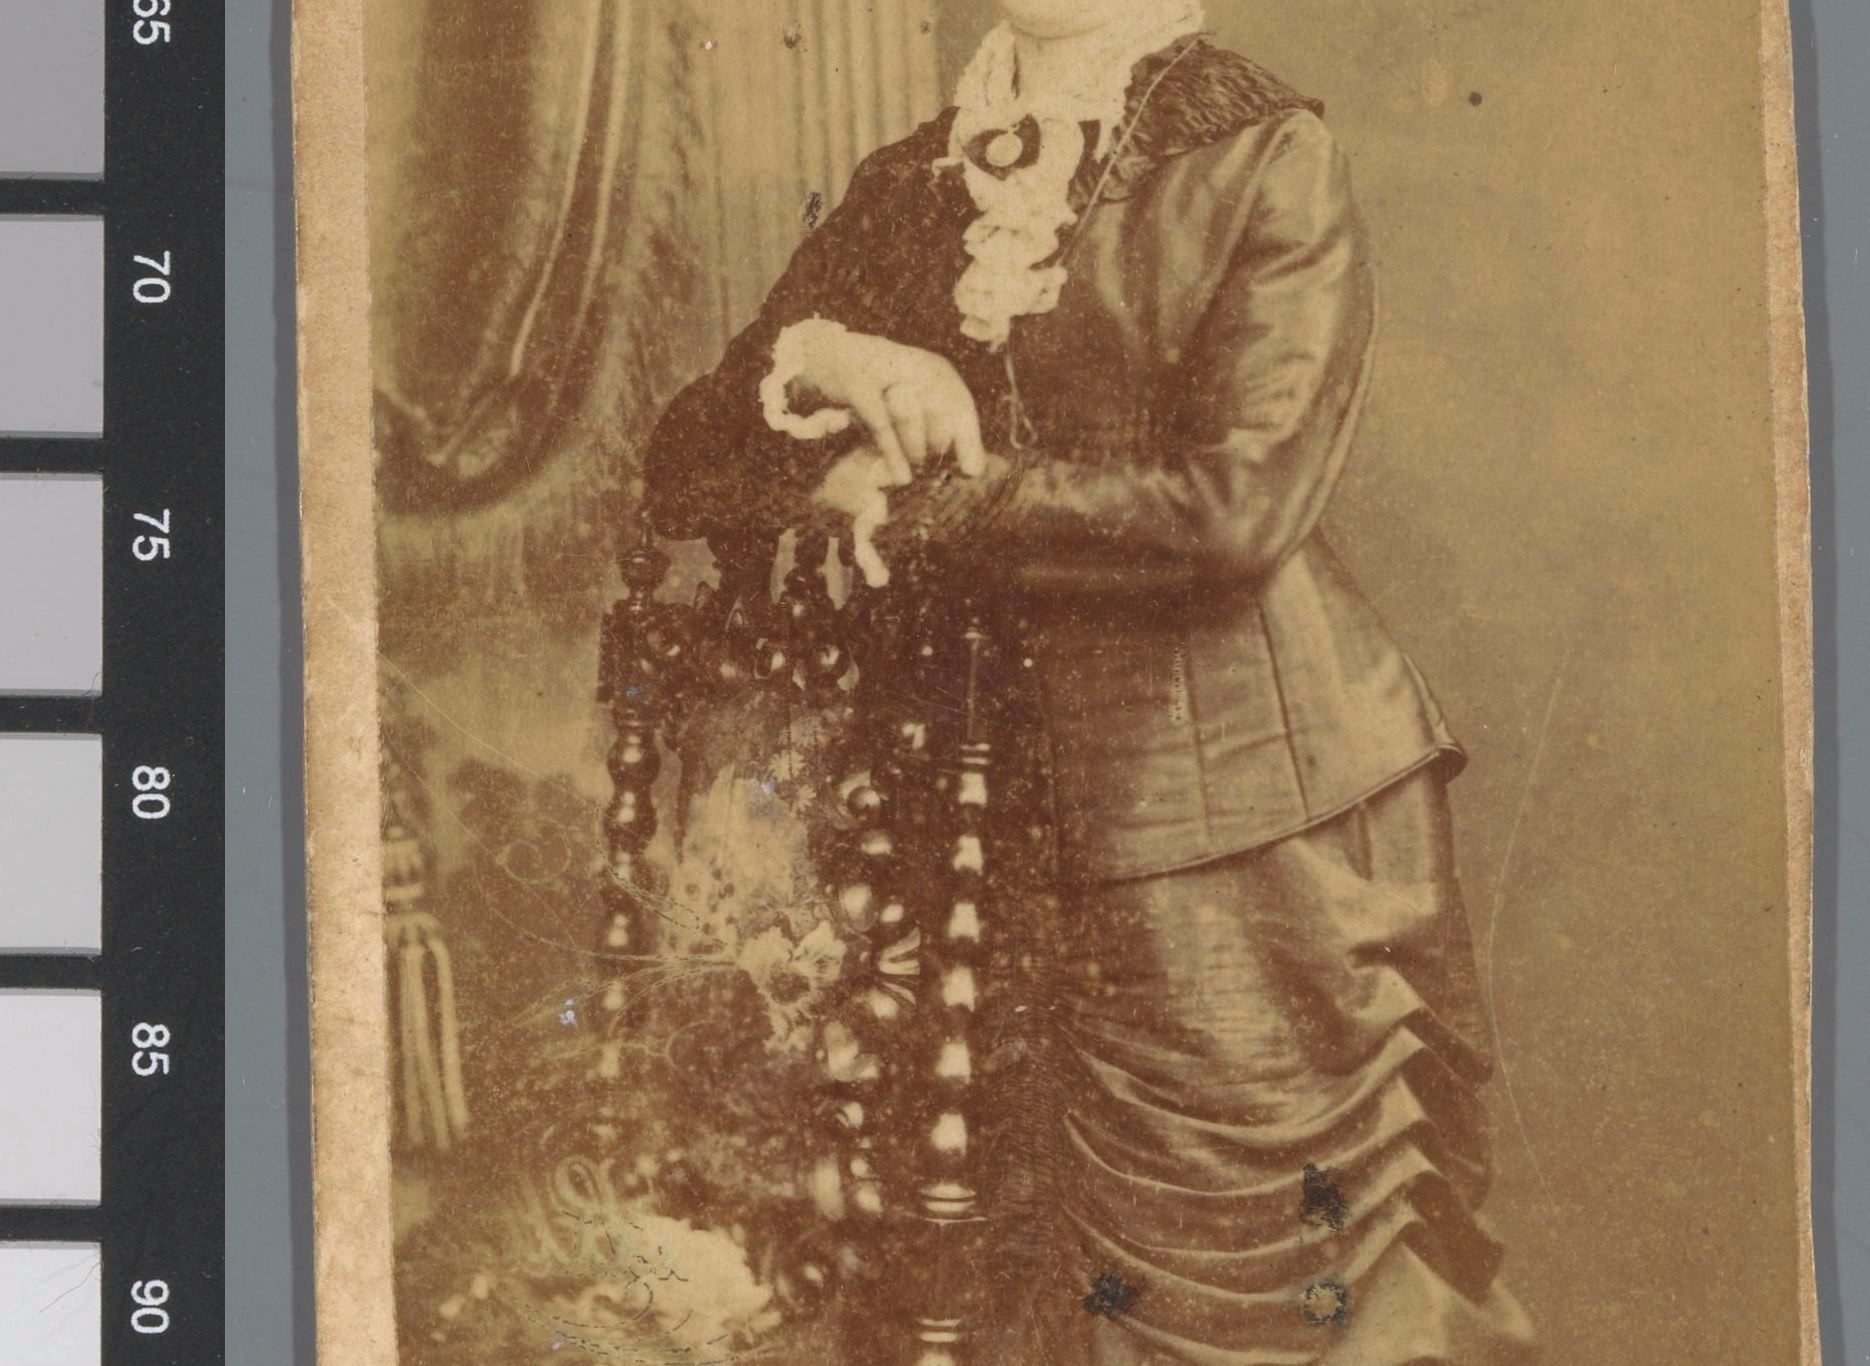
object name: photograph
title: Portret van een onbekende vrouw bij een stoel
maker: coenraad cornelis roskam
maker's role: fotograaf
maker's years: 1829-1892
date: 1881-1892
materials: cardboard, paper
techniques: albumen print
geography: amsterdam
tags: adult woman, anonymous historical person portrayed, amsterdam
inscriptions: inscription: ‘Photogr. Atelier/ C.C. Roskam/ Kerkstraat, Z.367/ over het Amstelveld/ het 8ste huis van de Utrechtsestraat/ Amsterdam.’